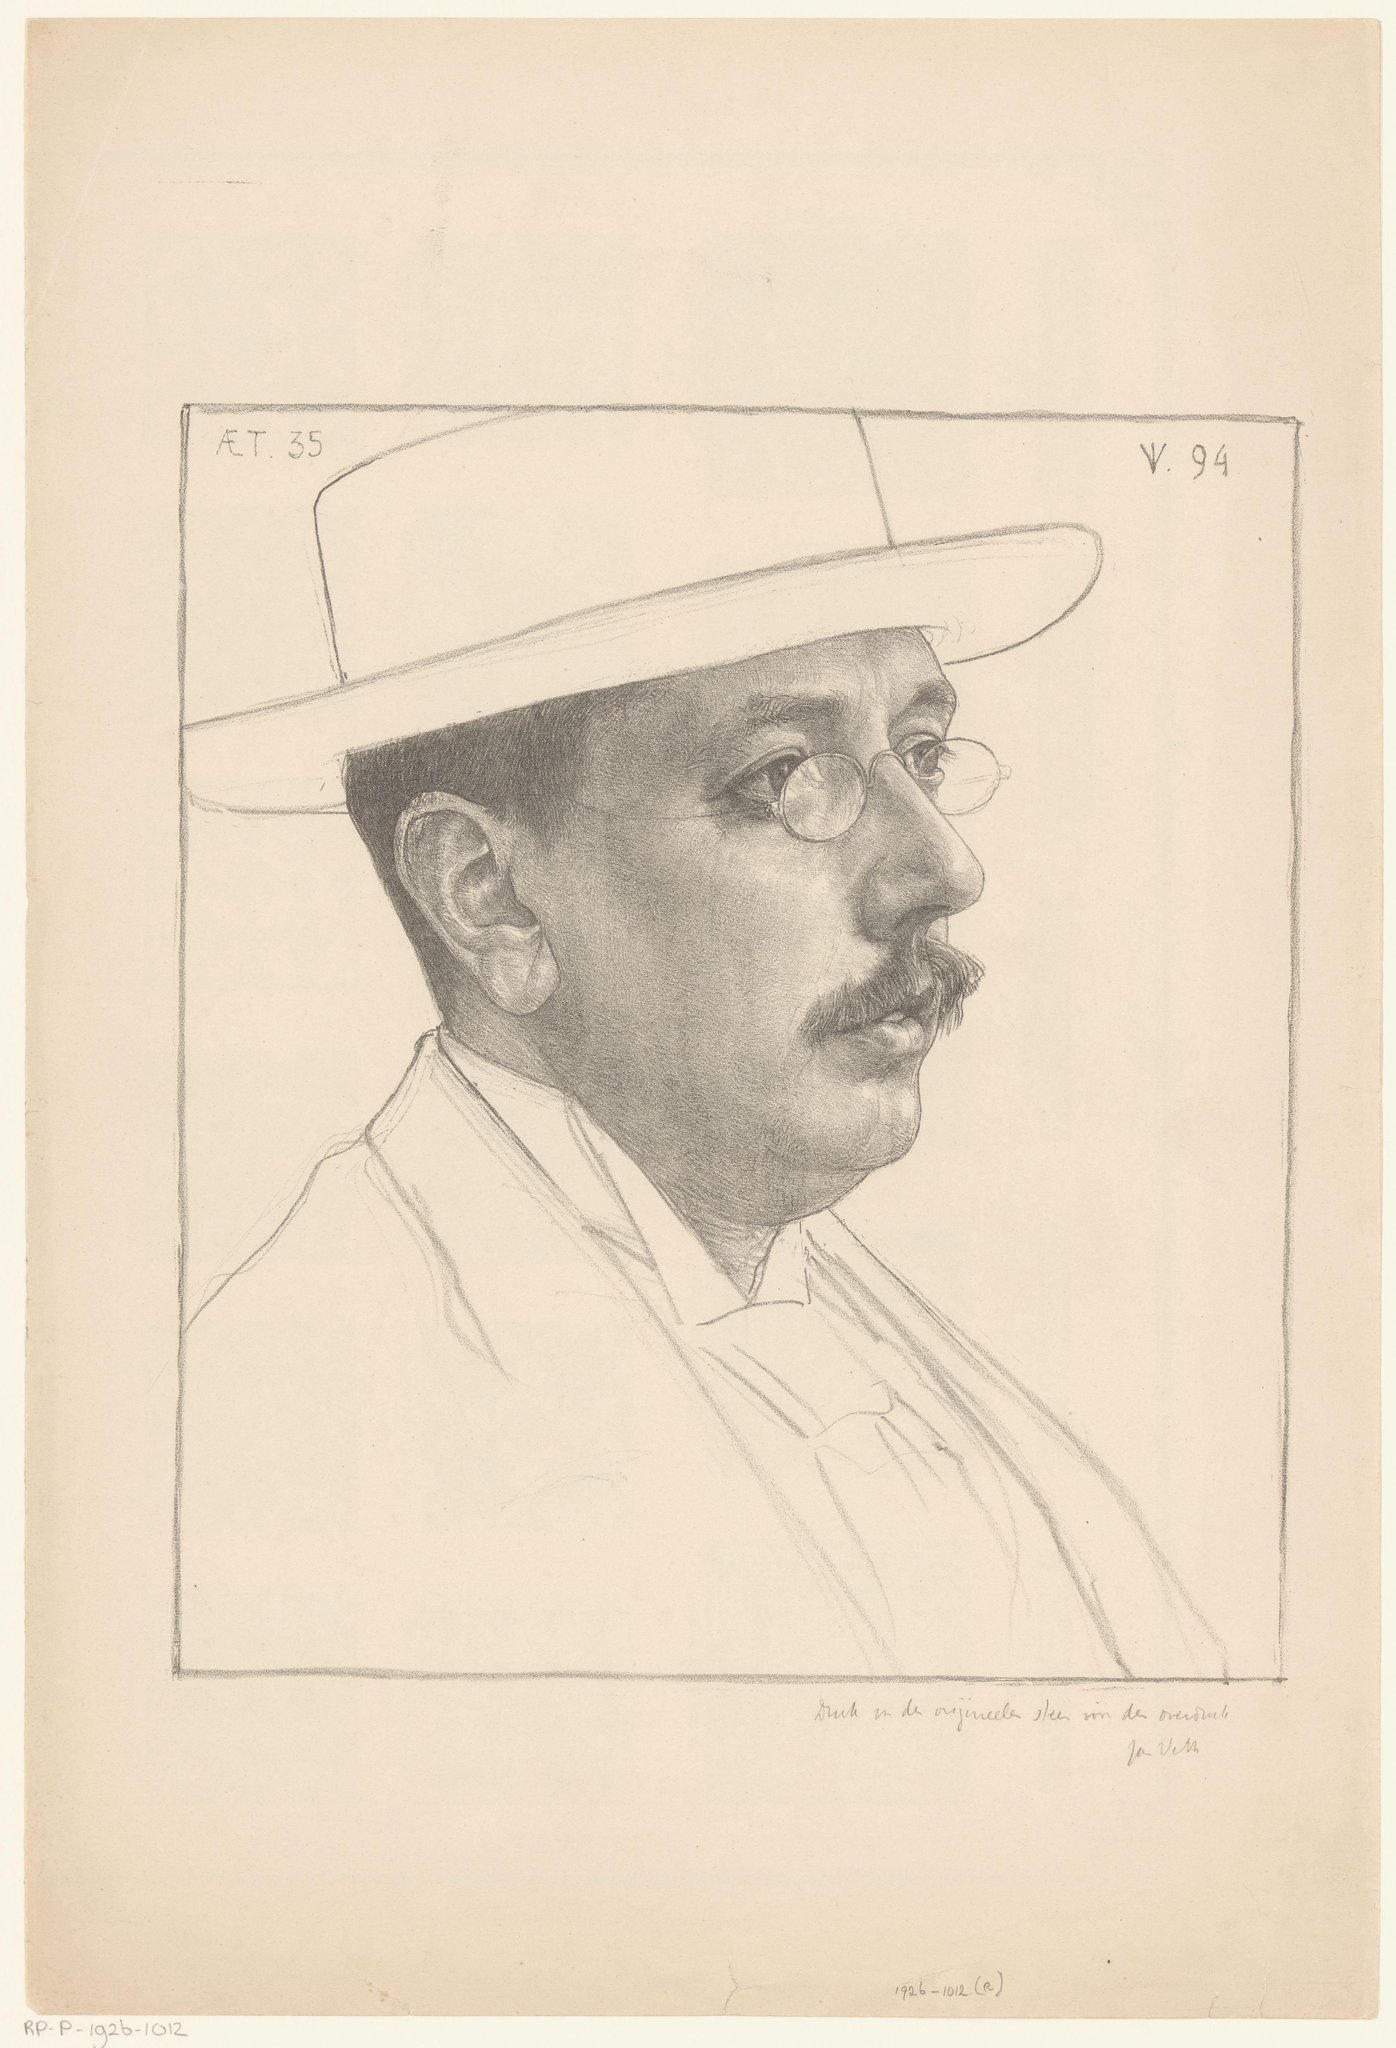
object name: print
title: Portret van Aegidius Willem Timmerman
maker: jan veth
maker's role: designer, draughtsman, painter, print maker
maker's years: 1864-1925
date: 1894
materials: paper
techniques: lithograph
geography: netherlands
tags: amsterdam, aegidius willem timmerman, historical persons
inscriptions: inscription: ‘Druk van de origineele steen vóór de overdruk / Jan Veth’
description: Het opschrift duidt mogelijk op het productieproces waarbij Jan Veth op een steen tekende die vervolgens werd overgezet naar een zogenaamde 'machinesteen' waardoor, middels de snelpers, een hogere oplage gedrukt kon worden.